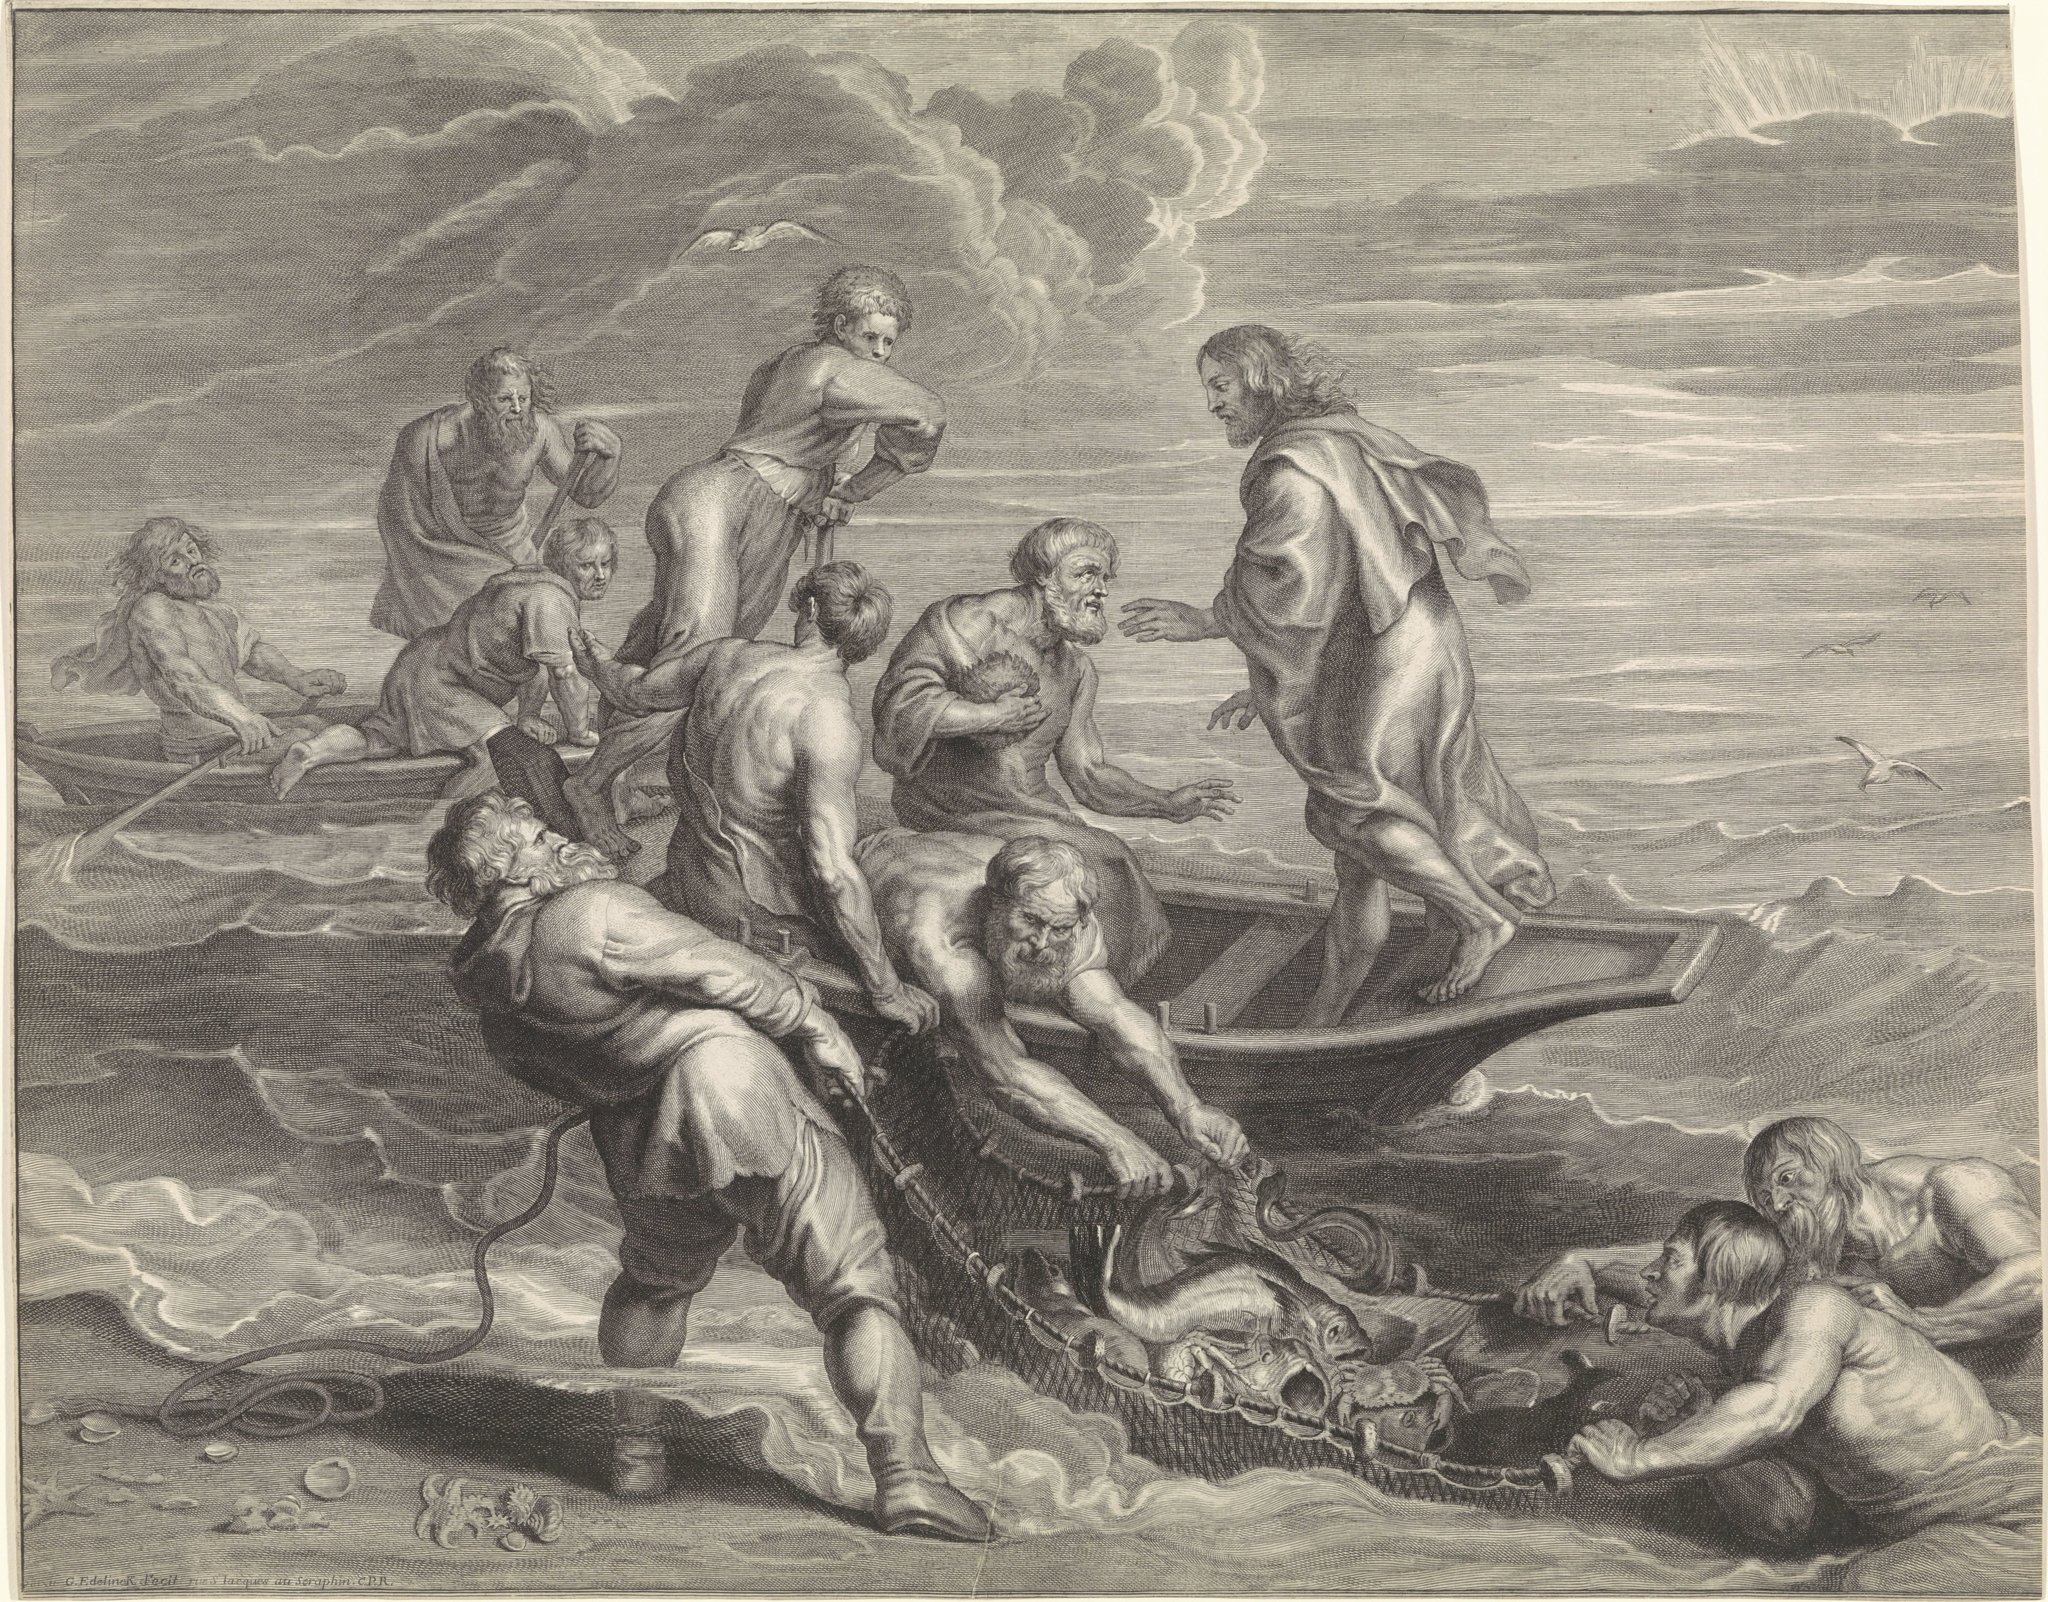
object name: print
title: Wonderbaarlijke visvangst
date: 1666-1707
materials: paper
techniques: engraving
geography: paris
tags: the miraculous draught of fishes (before the resurrection) on the lake of gennesaret (sea of galilee); james and john helping to bring in the nets (luke 5:1-11)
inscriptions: collector's mark: Lugt 240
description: Christus staat in de vissersboot van Petrus terwijl vier mannen een overvol visnet binnen halen. Een vijfde visser wenkt een tweede boot om te komen helpen. Petrus kijkt Christus verbaasd aan, vanwege zijn aanvankelijke twijfel over de te vangen vis. Luc. 5:1-11